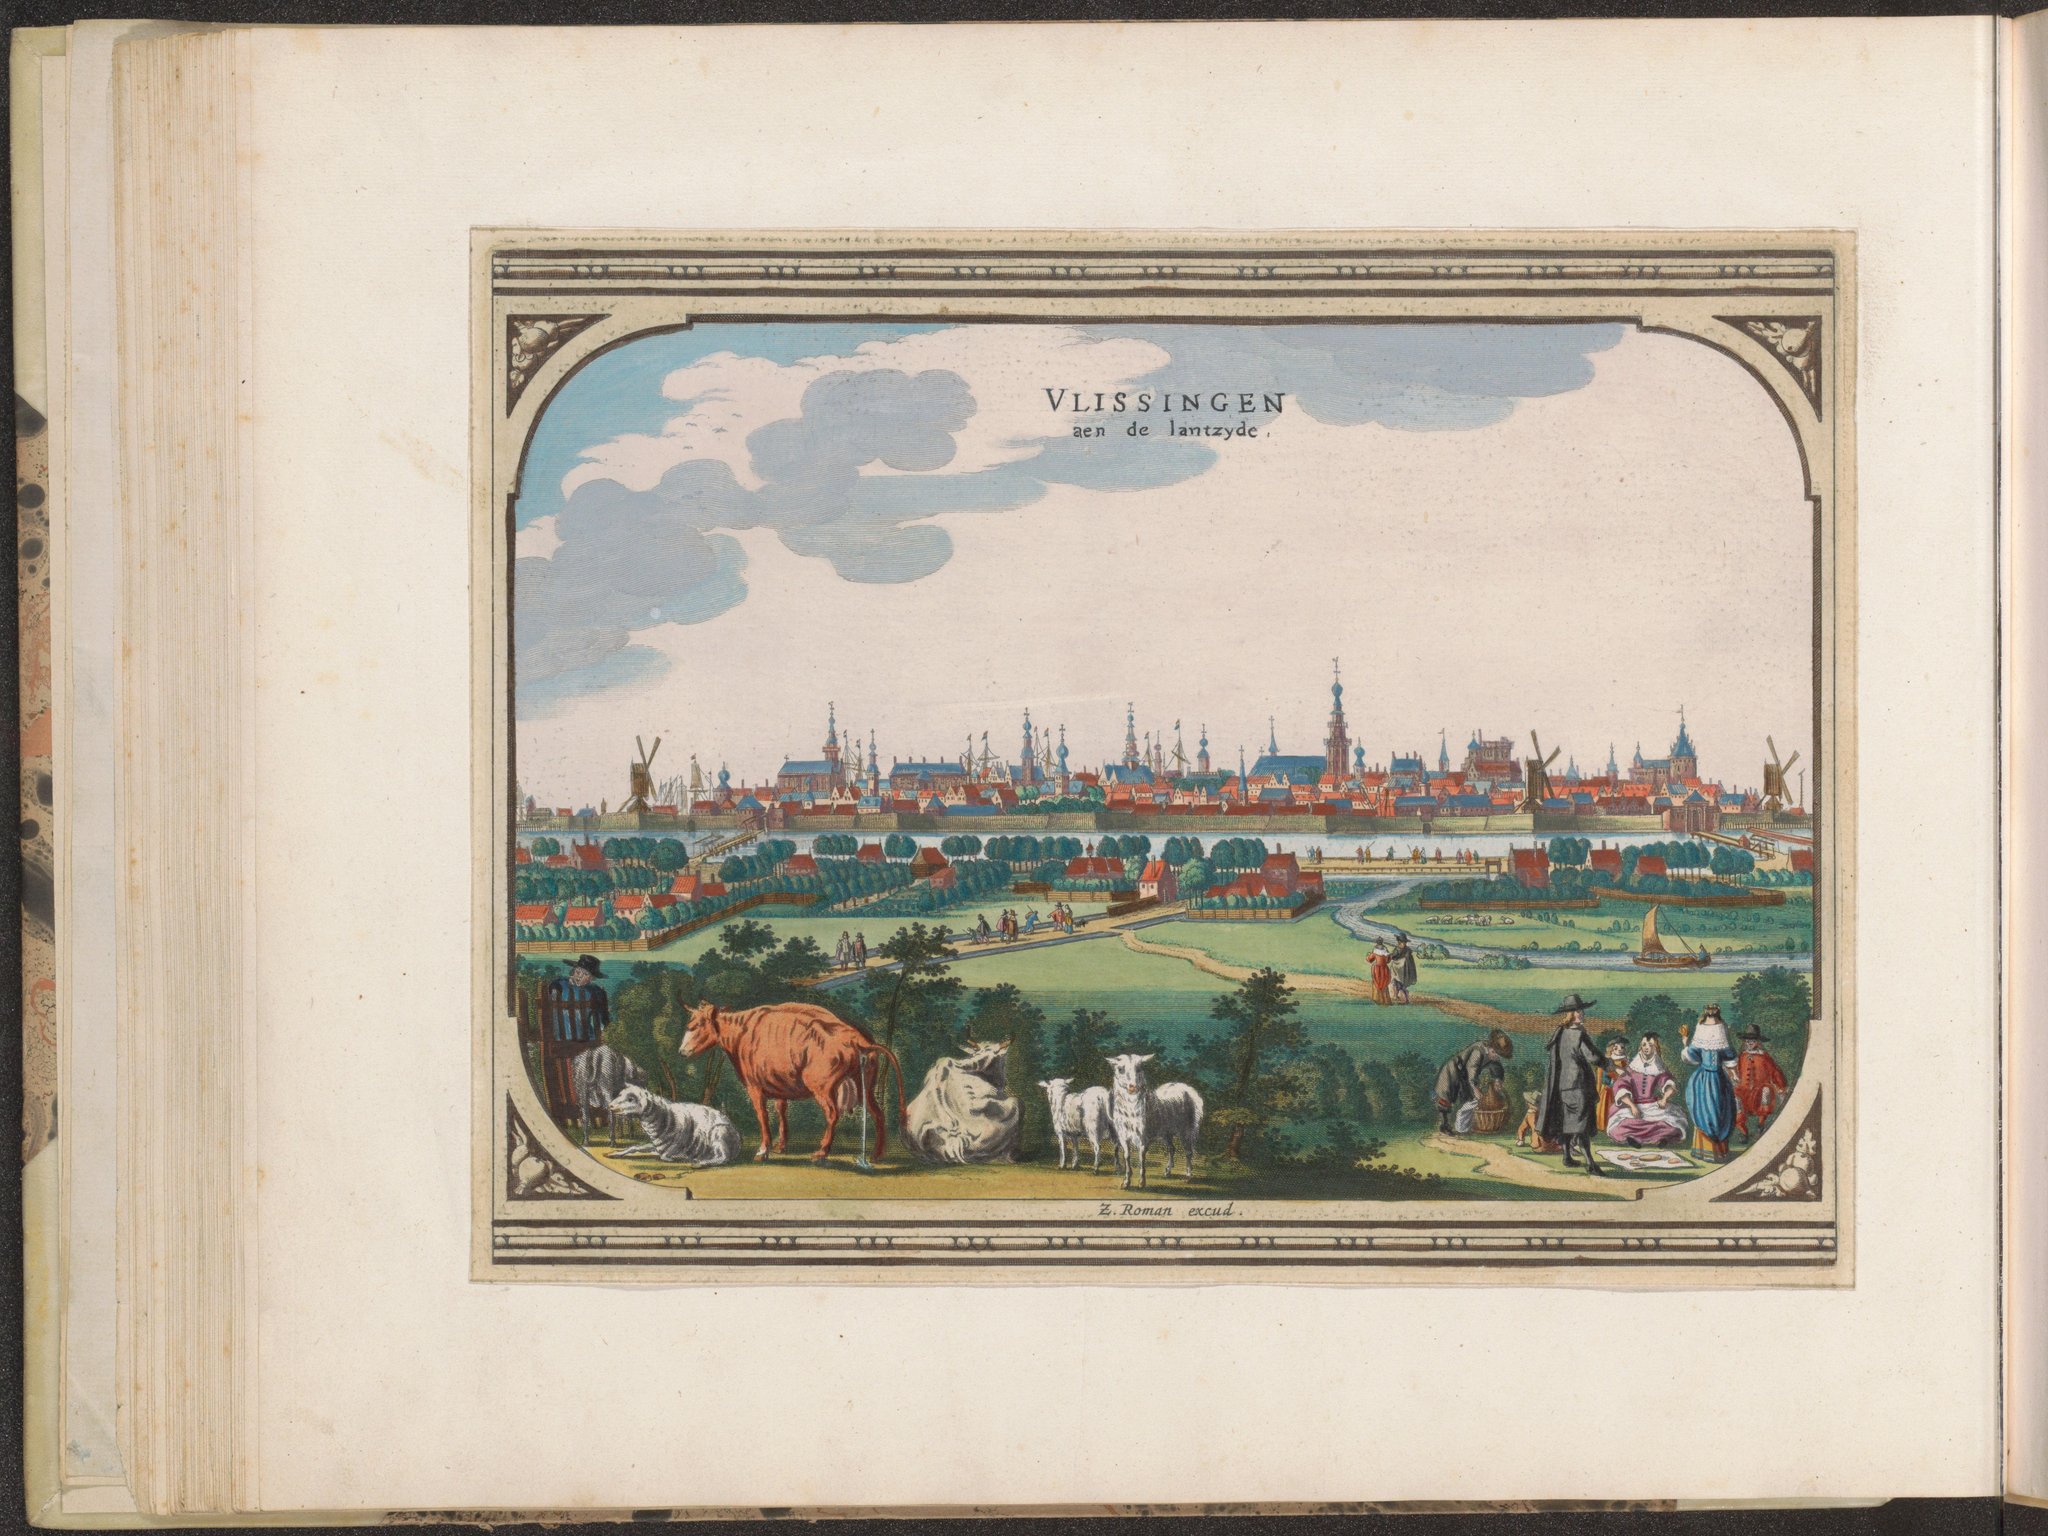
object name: album leaf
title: Speculum Zelandiae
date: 1662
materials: paper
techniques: etching, hand coloring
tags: city-view, and landscape with man-made constructions, cow, picnic, alfresco, 'déjeuner sur l'herbe', flushing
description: Gezicht op de stad Vlissingen met twee koeien en drie geiten. Eén van de koeien doet zijn behoefte. Rechts op de voorgrond zijn enkele welgestelden heren en dames aan het picknicken. De prent maakt deel uit van een album.